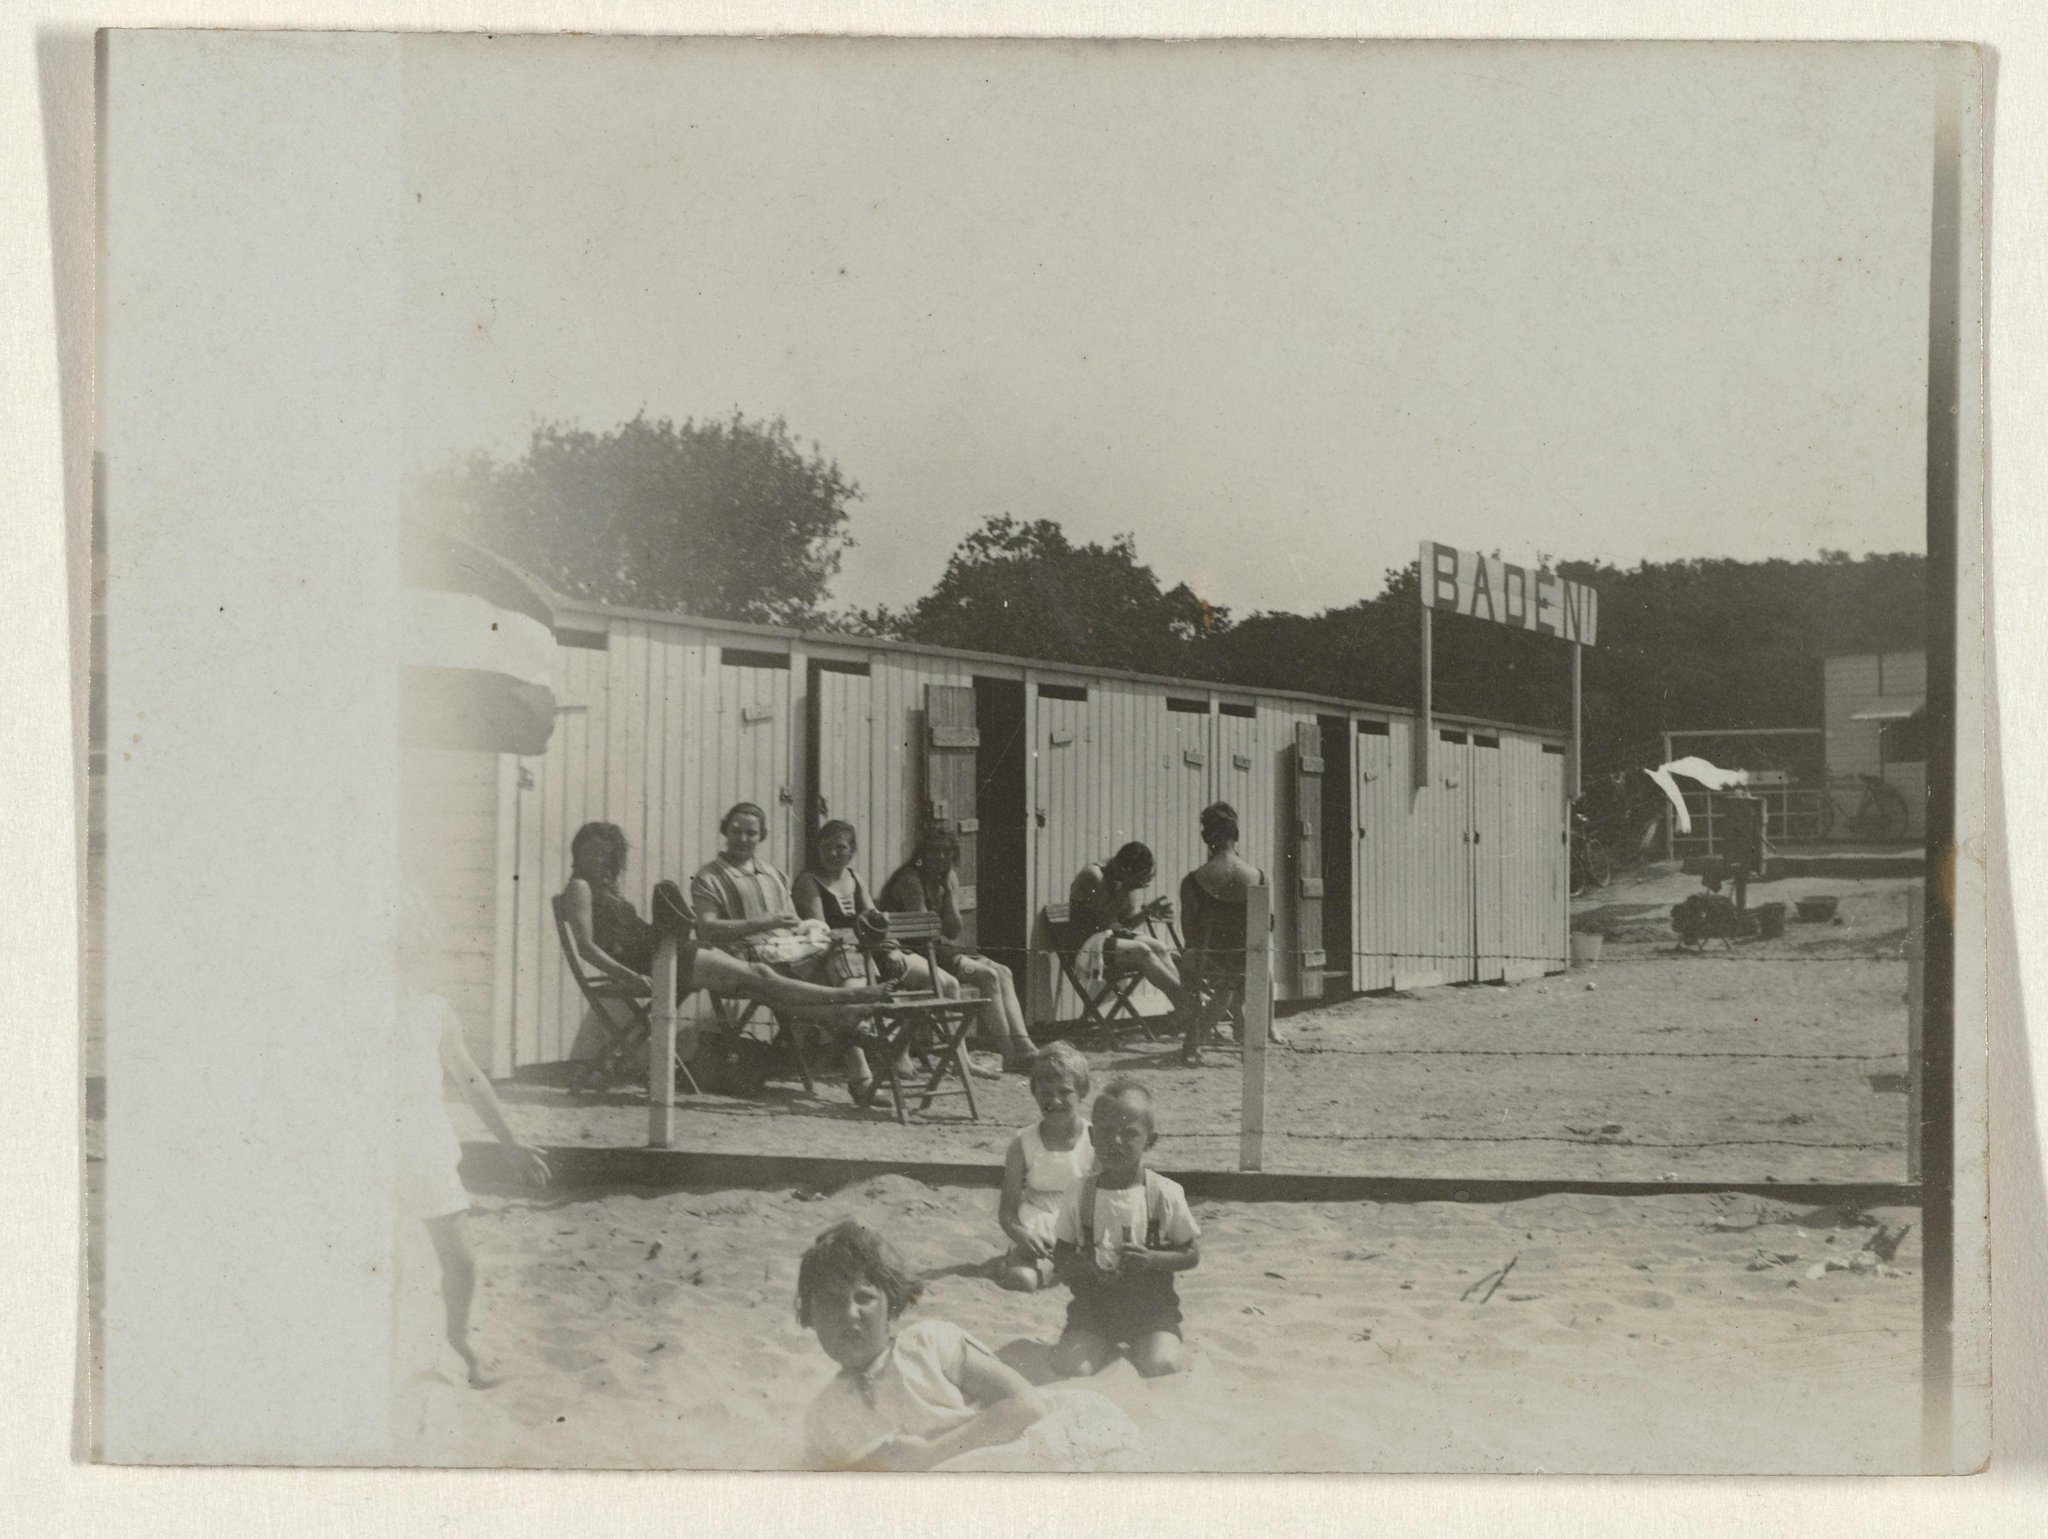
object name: photograph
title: Badgasten bij De Wijde Blik op het strand van Valkeveen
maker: Anonymous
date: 1925-1940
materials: paper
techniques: gelatin silver print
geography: valkeveen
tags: beach (as place of recreation)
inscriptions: inscription: ‘AF’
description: Strand (van Vinkeveen?) met badgasten en kinderen die in het zand spelen.